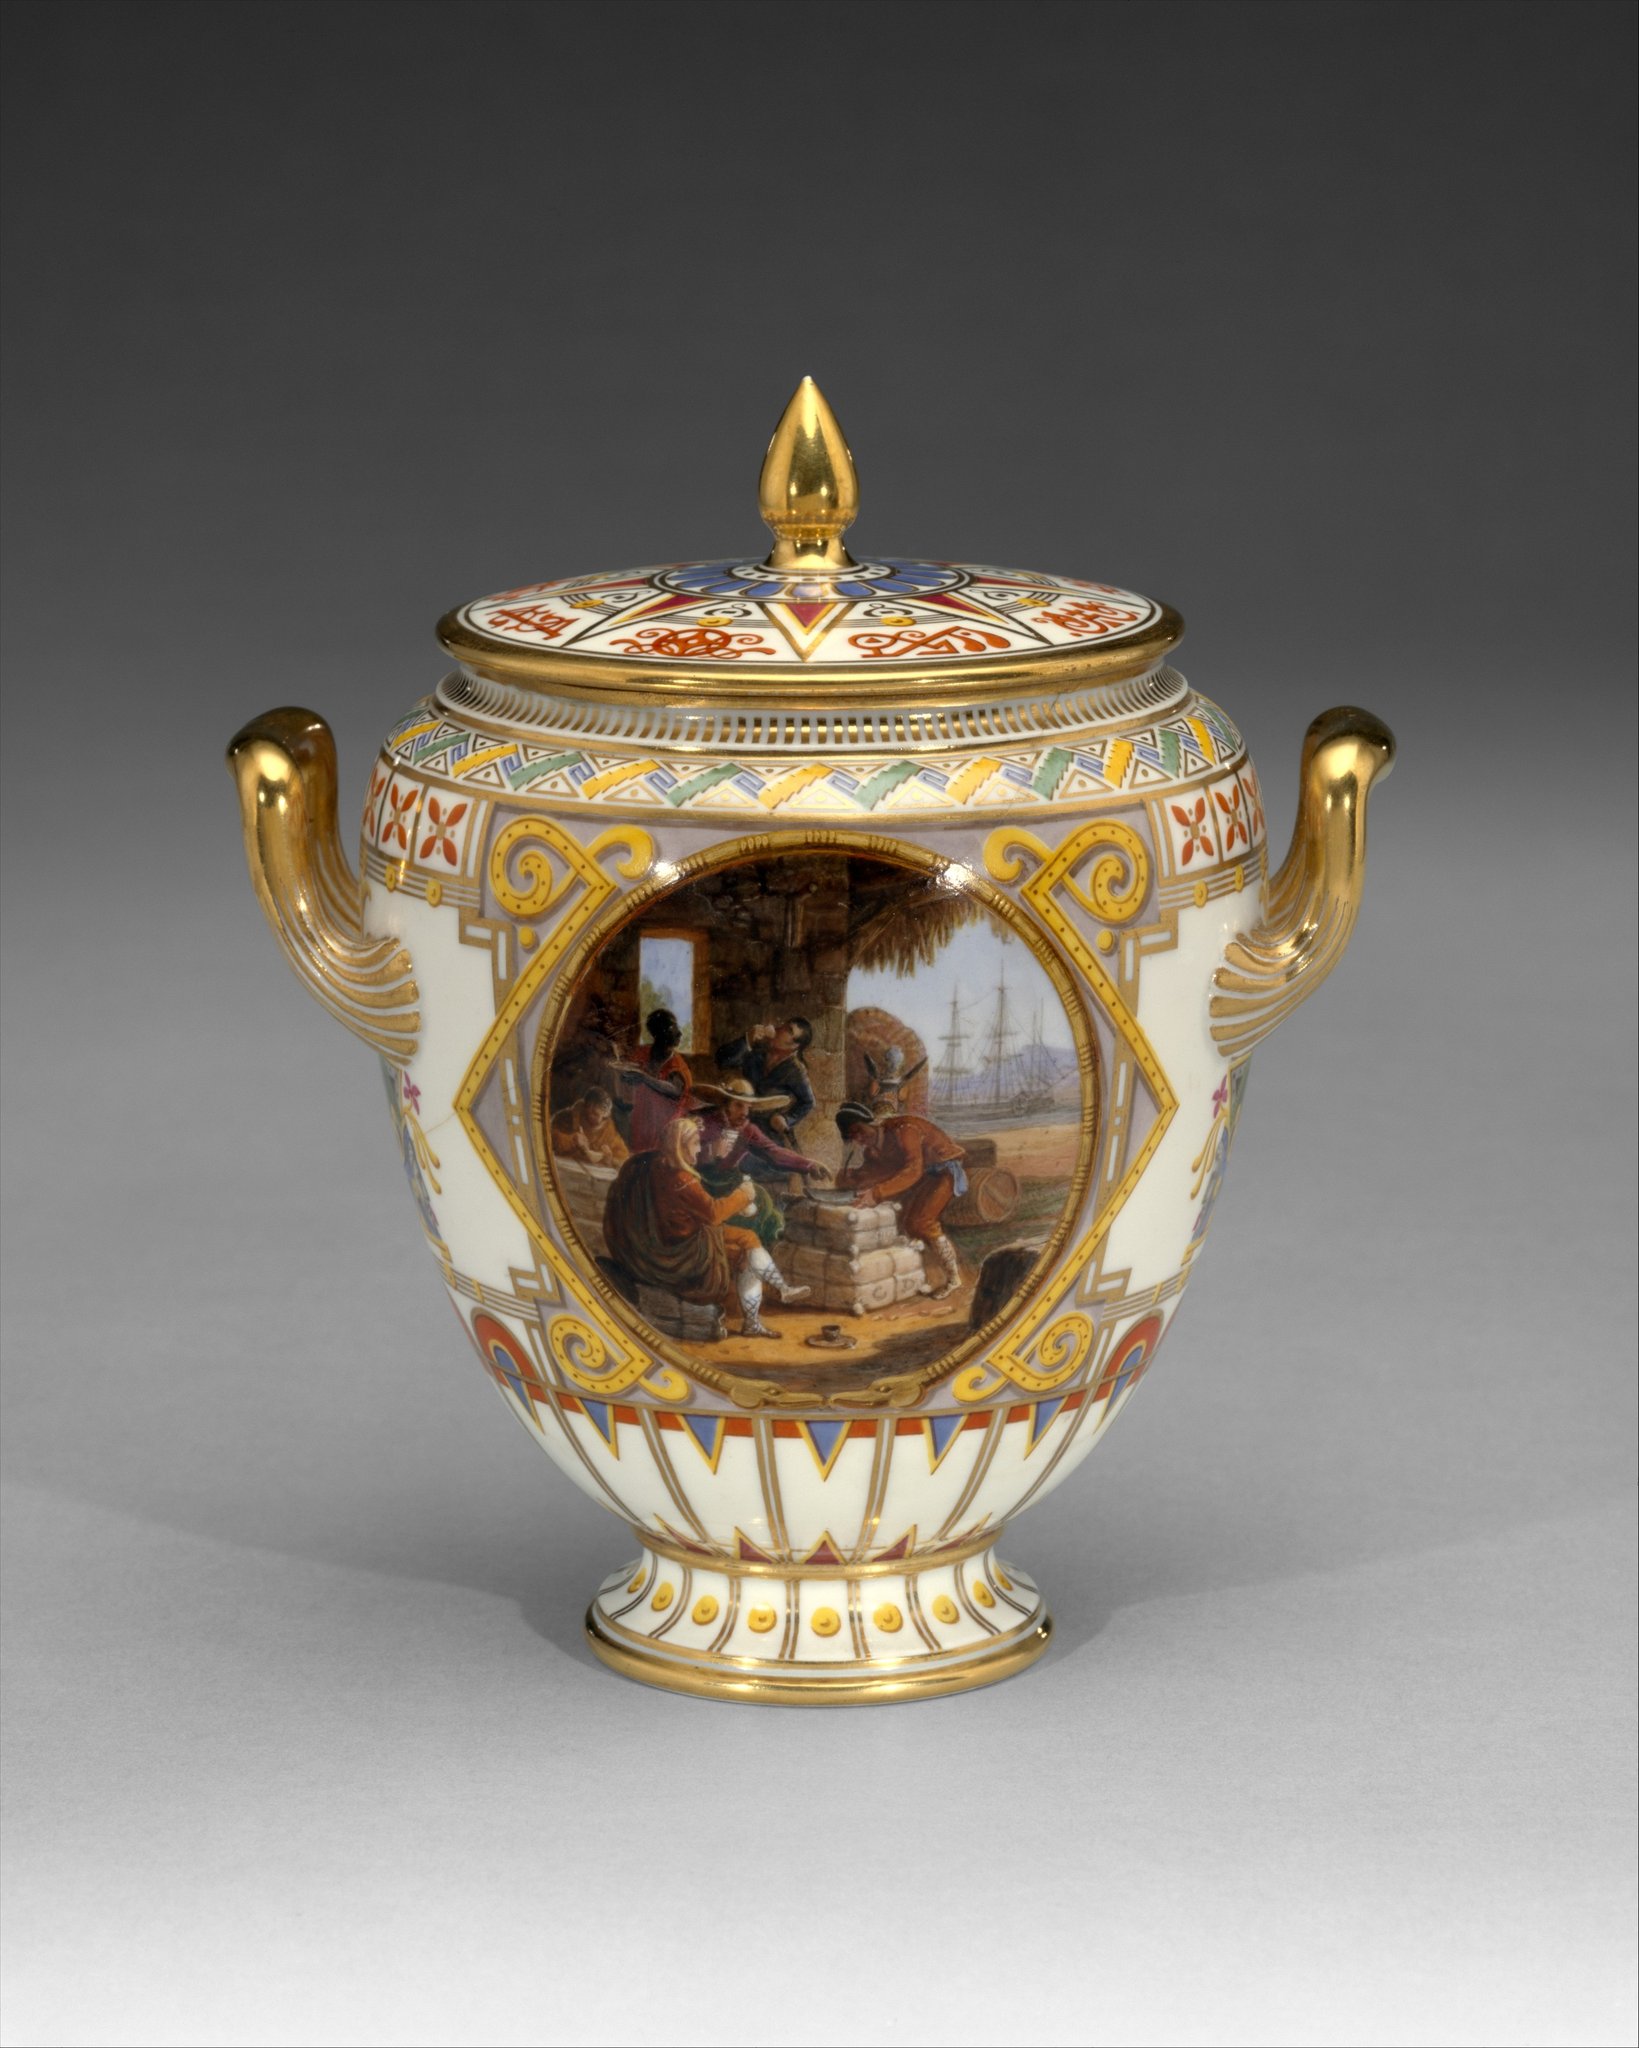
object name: sugar bowl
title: Sugar bowl (pot à sucre ovoïde)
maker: sèvres manufactory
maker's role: manufactory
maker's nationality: french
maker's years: 1740-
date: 1836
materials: enamel, gold, hard paste porcelain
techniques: polychrome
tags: men,drinking,writing,ships